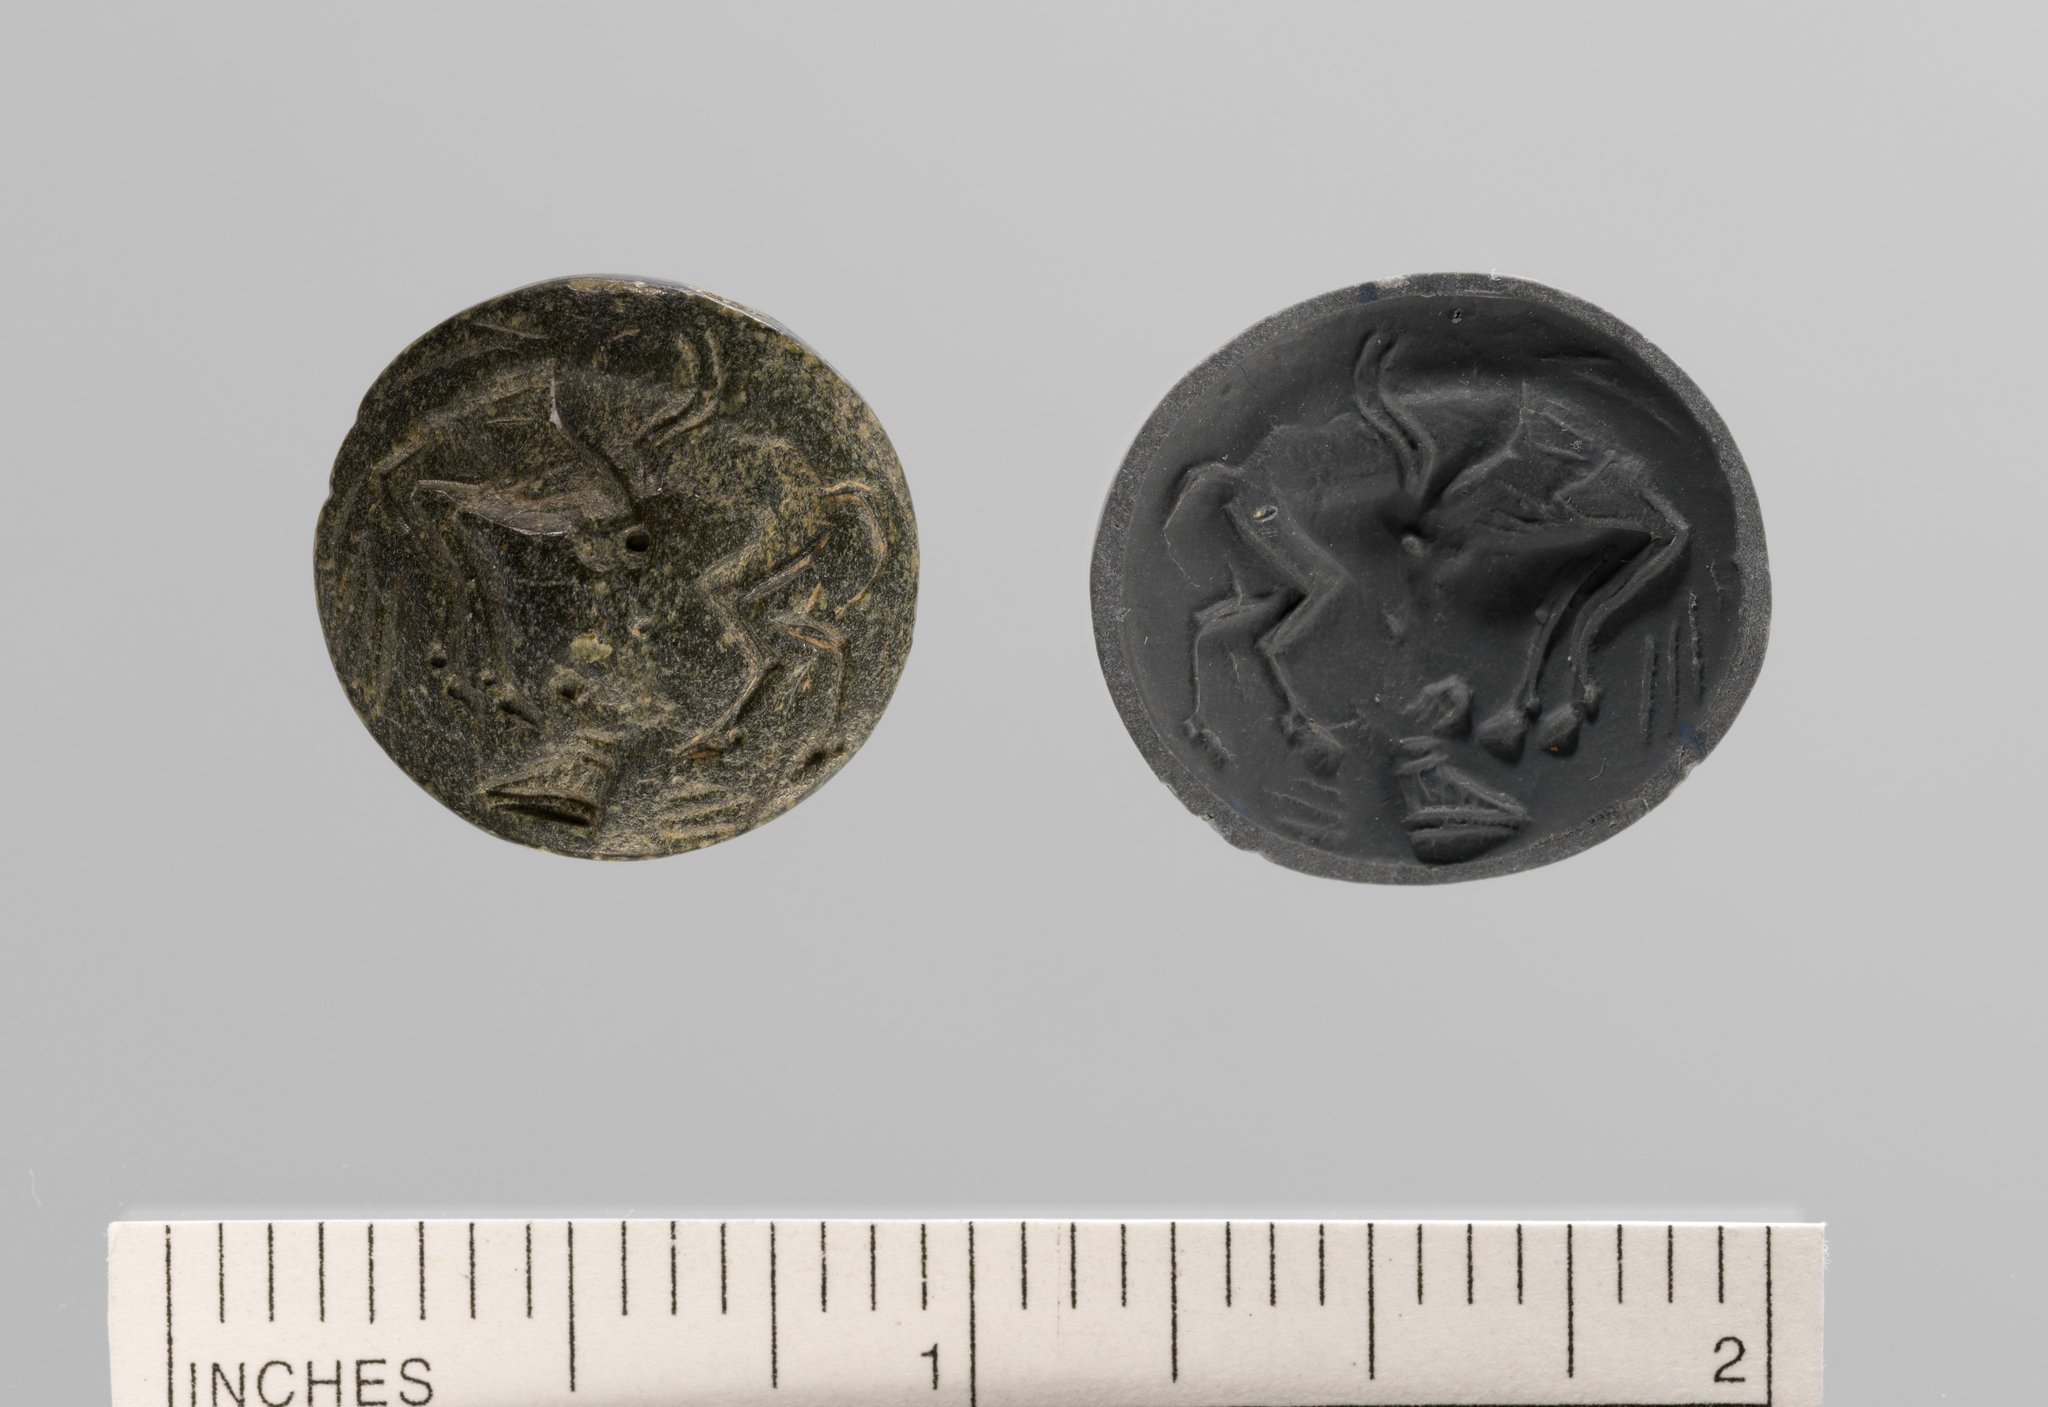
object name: seal, lentoid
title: Serpentine Lentoid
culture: minoan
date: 1450-1375 BCE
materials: stone